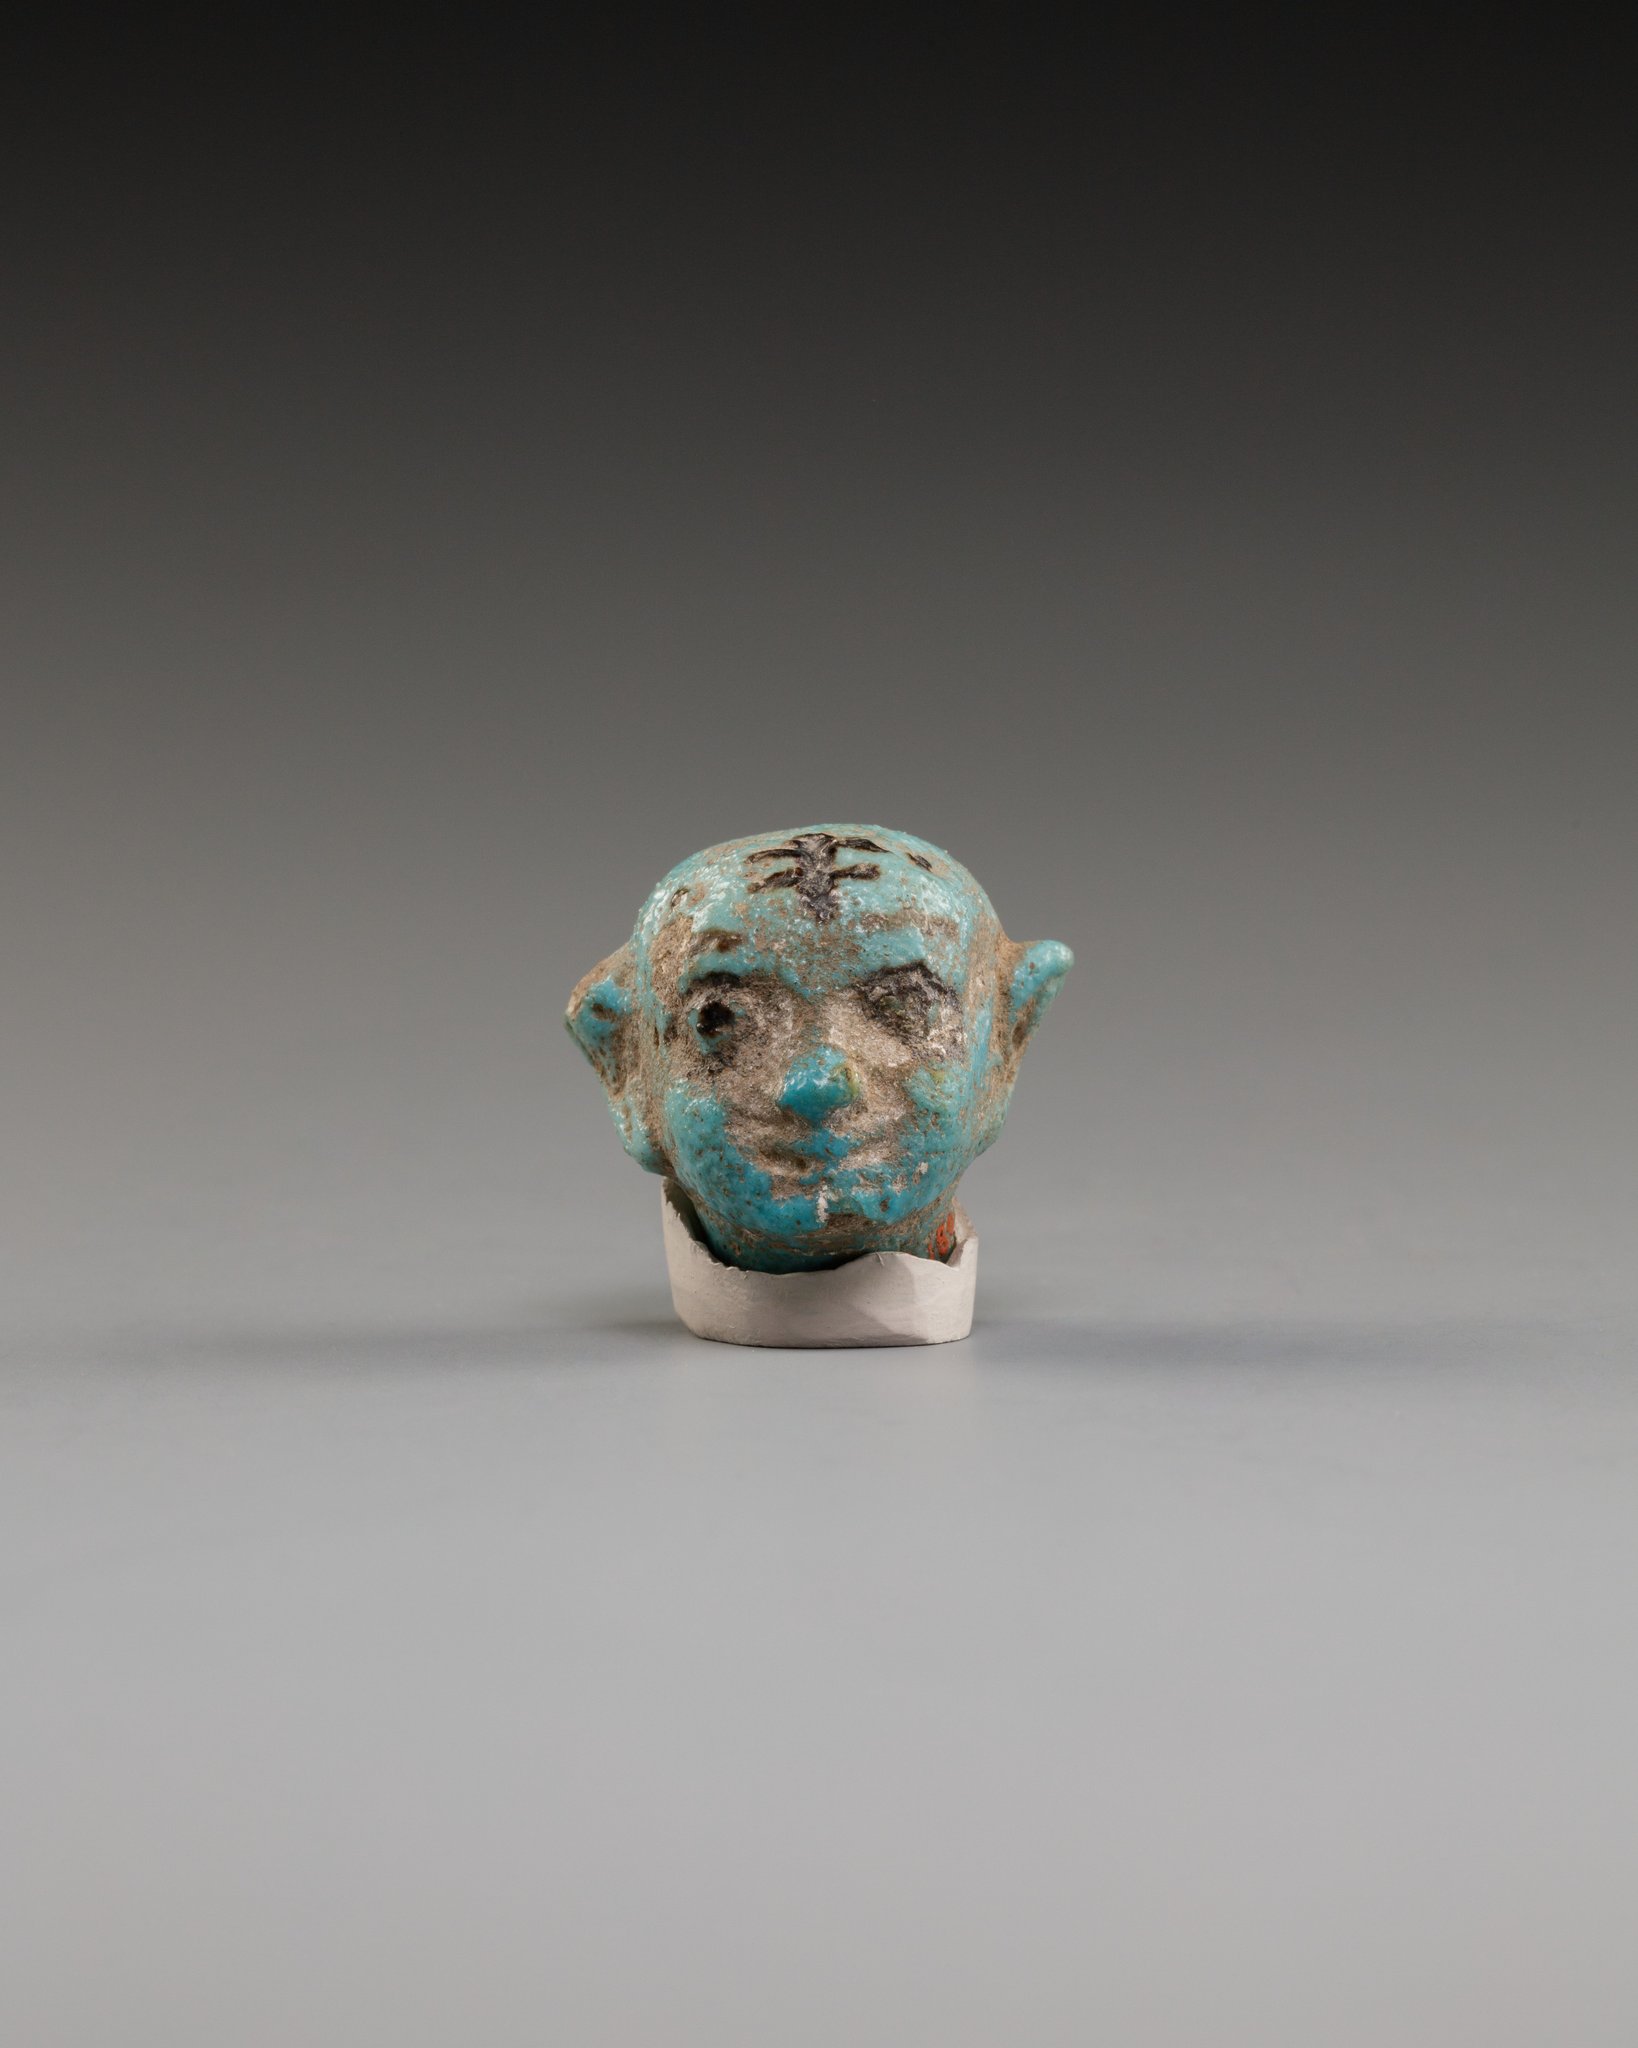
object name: head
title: Head from female figurine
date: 1981-1640 BCE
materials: faience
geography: egypt